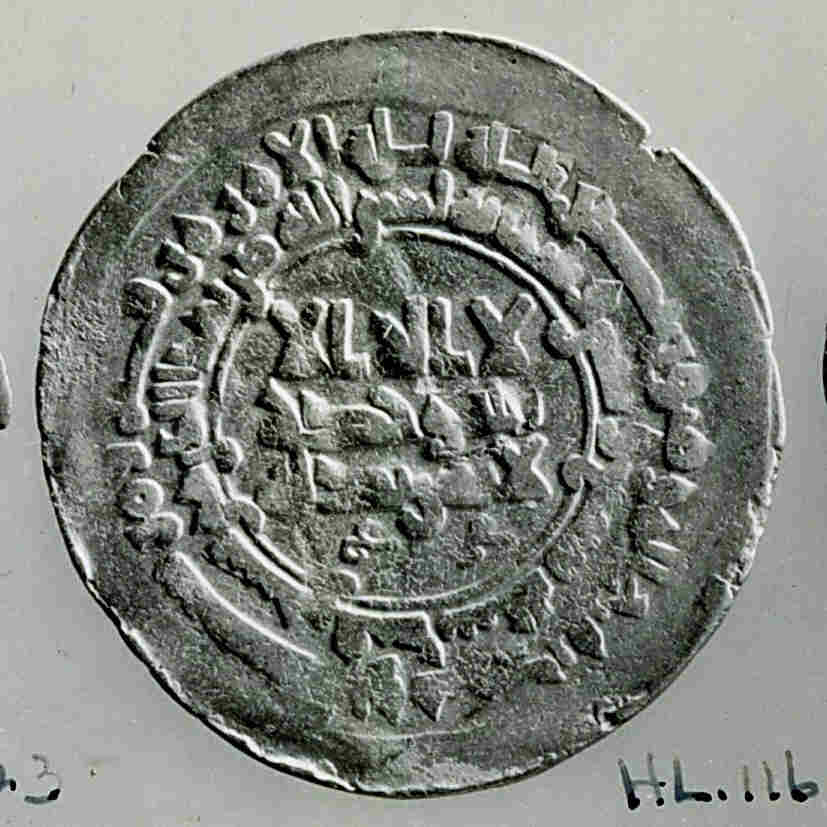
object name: coin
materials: silver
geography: uzbekistan